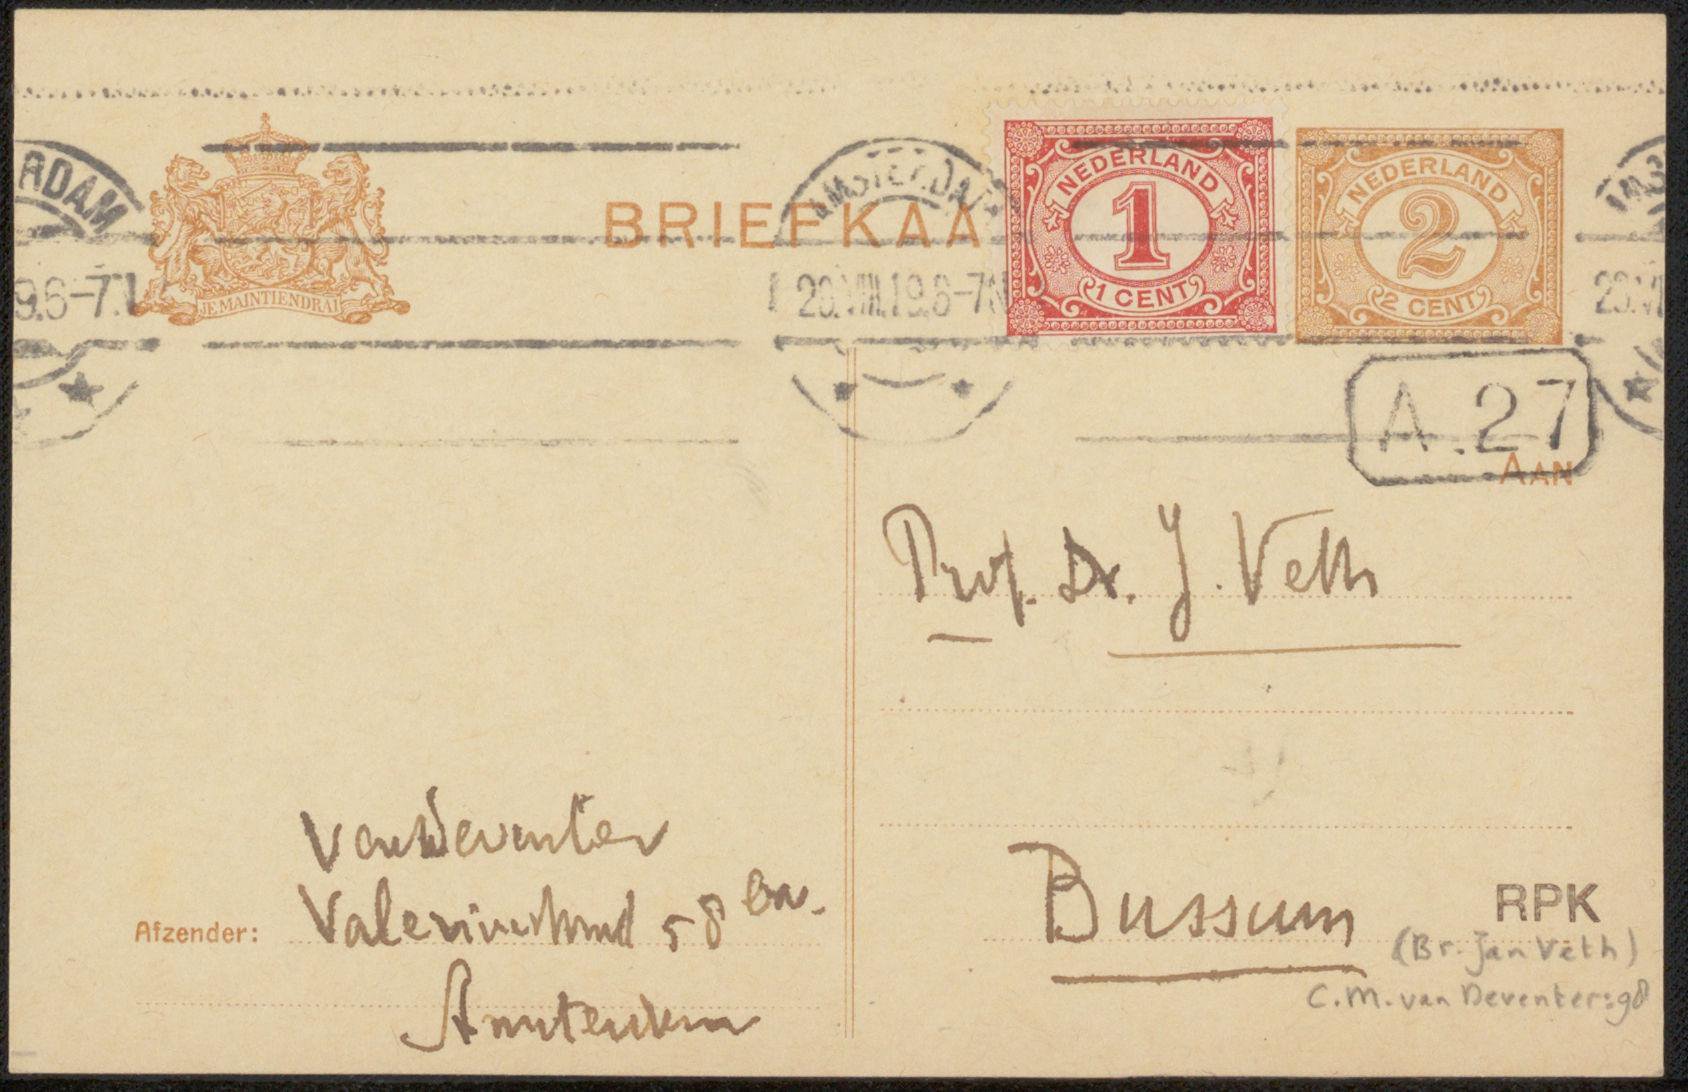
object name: postcard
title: Briefkaart aan Jan Veth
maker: chap van deventer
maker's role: kunstcriticus, scheikundige, schrijver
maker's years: 1860-1931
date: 1919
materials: cardboard, ink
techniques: pen, writing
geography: amsterdam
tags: painter, draughtsman, designer, jan veth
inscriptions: collector's mark: ‘RPK’